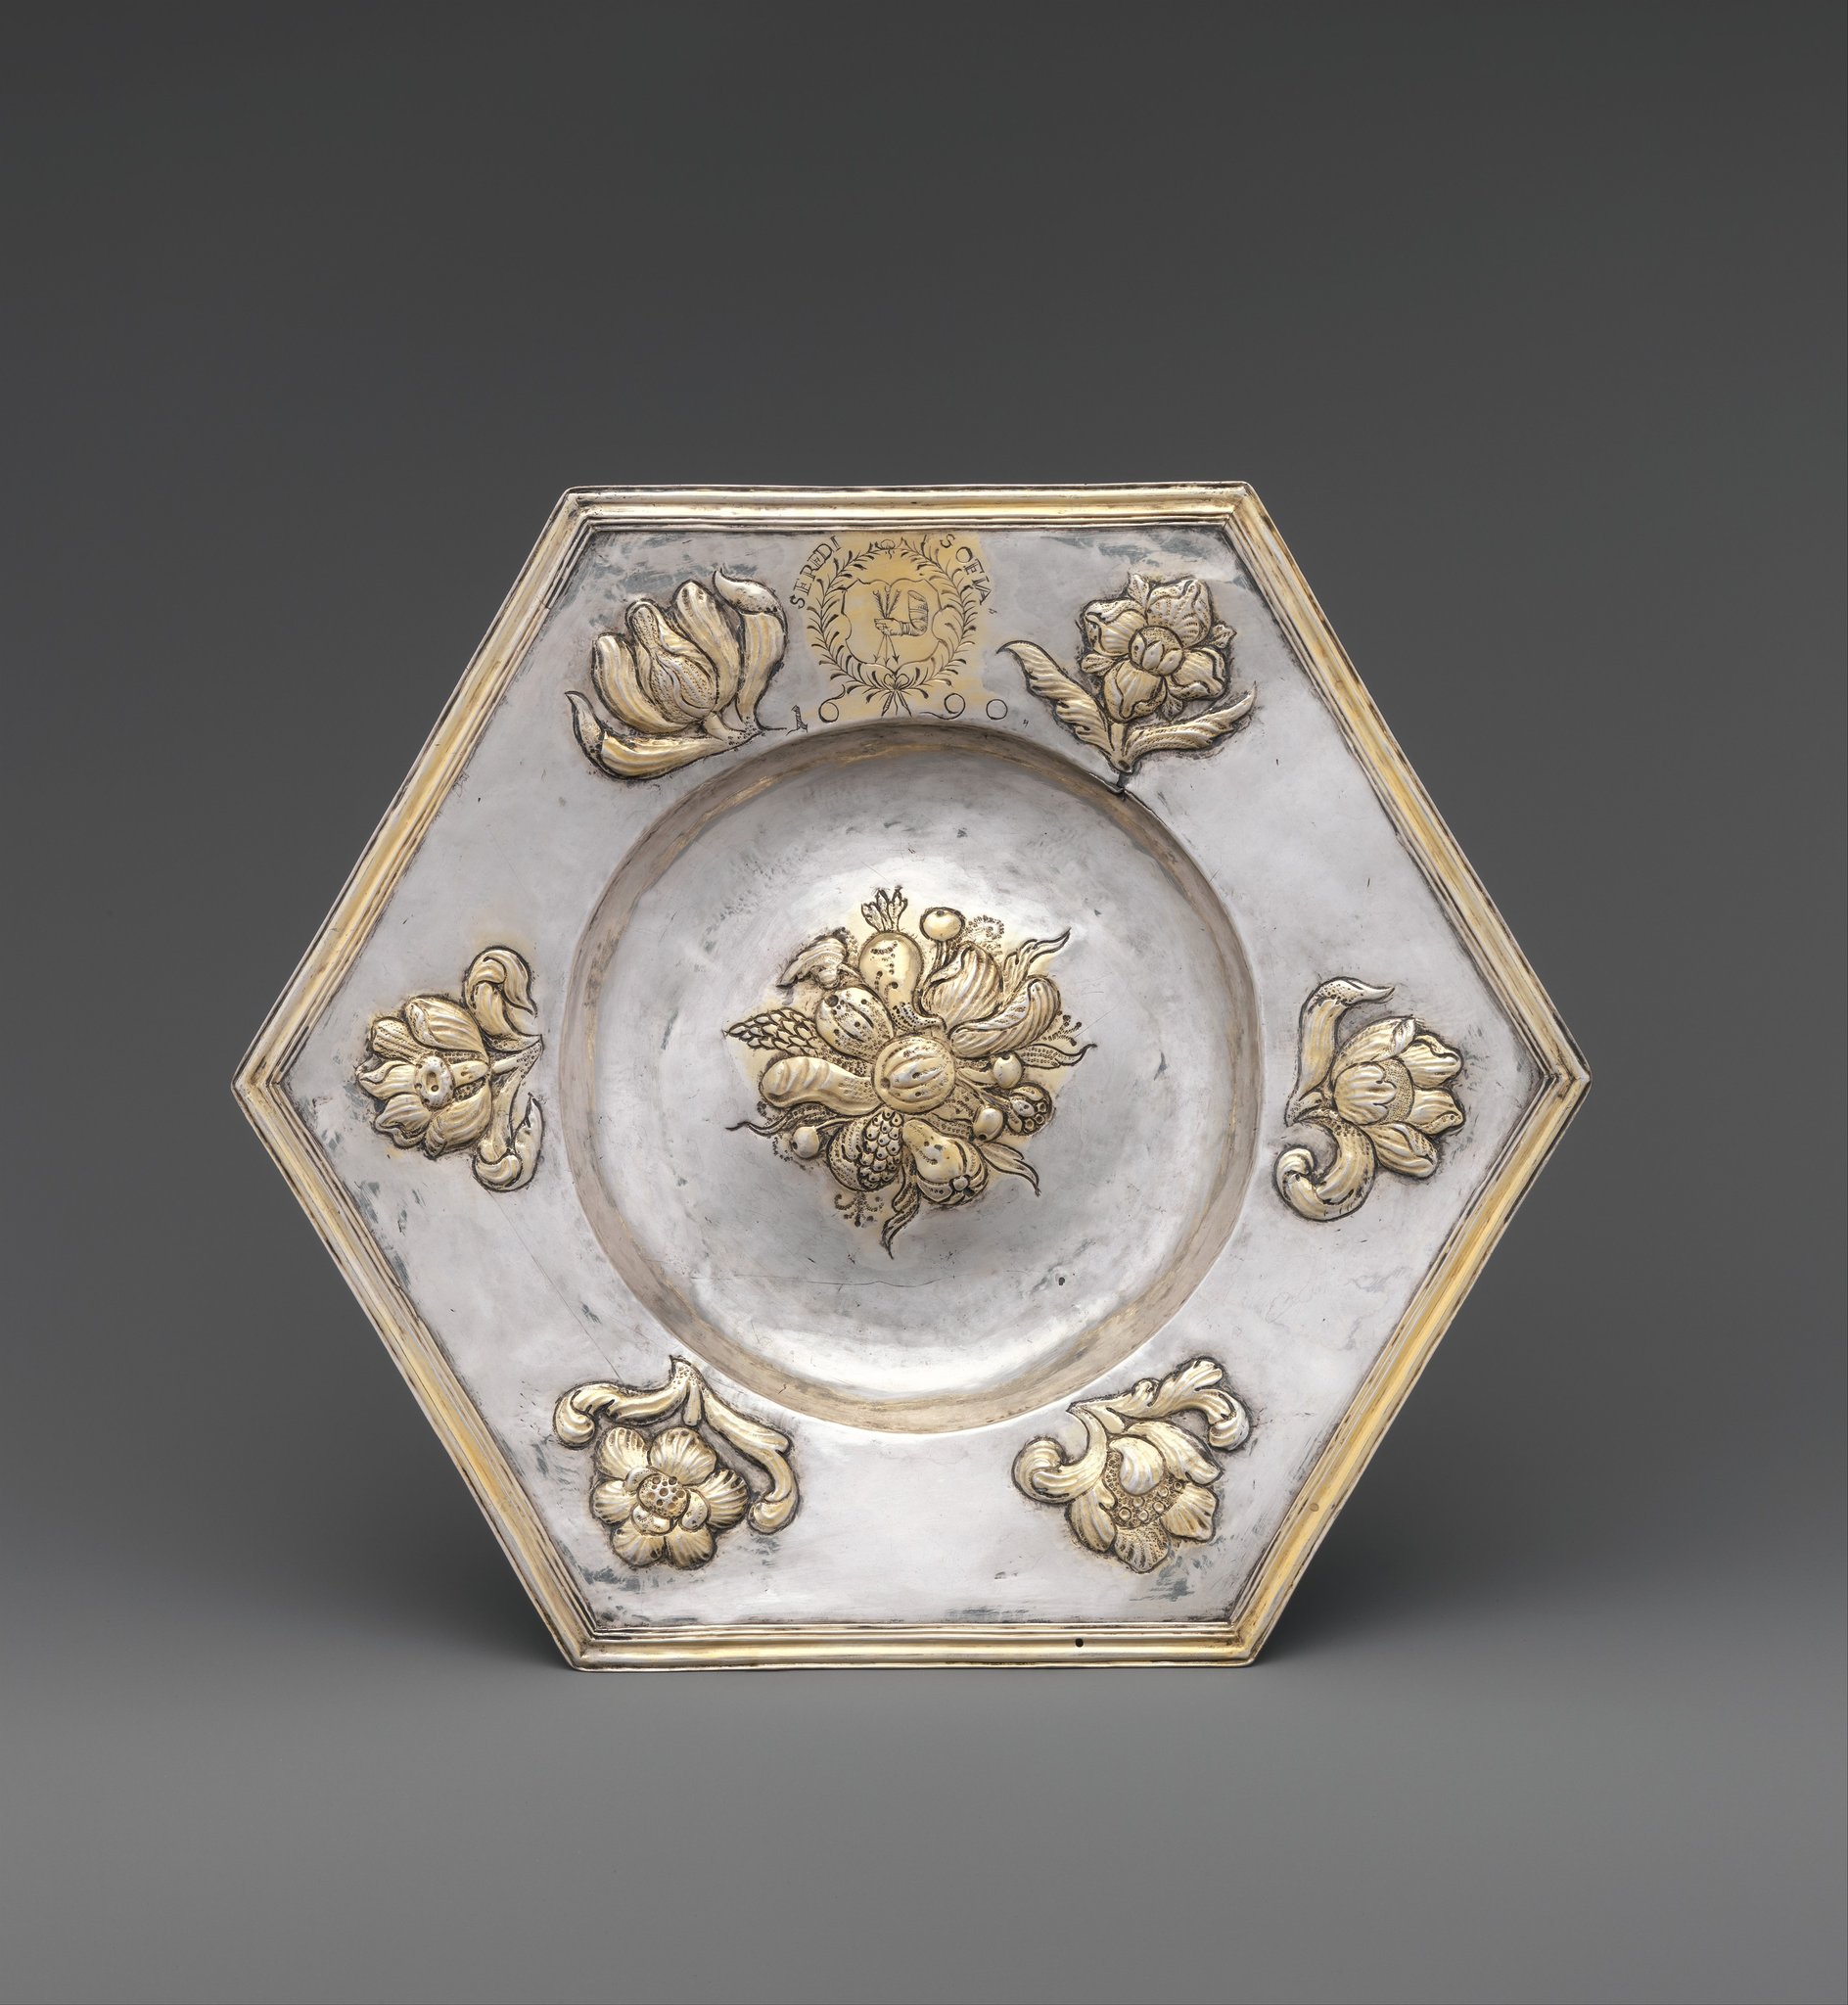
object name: dish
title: Dish (one of a pair)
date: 1634-1666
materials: silver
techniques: gilding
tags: flowers,insignia